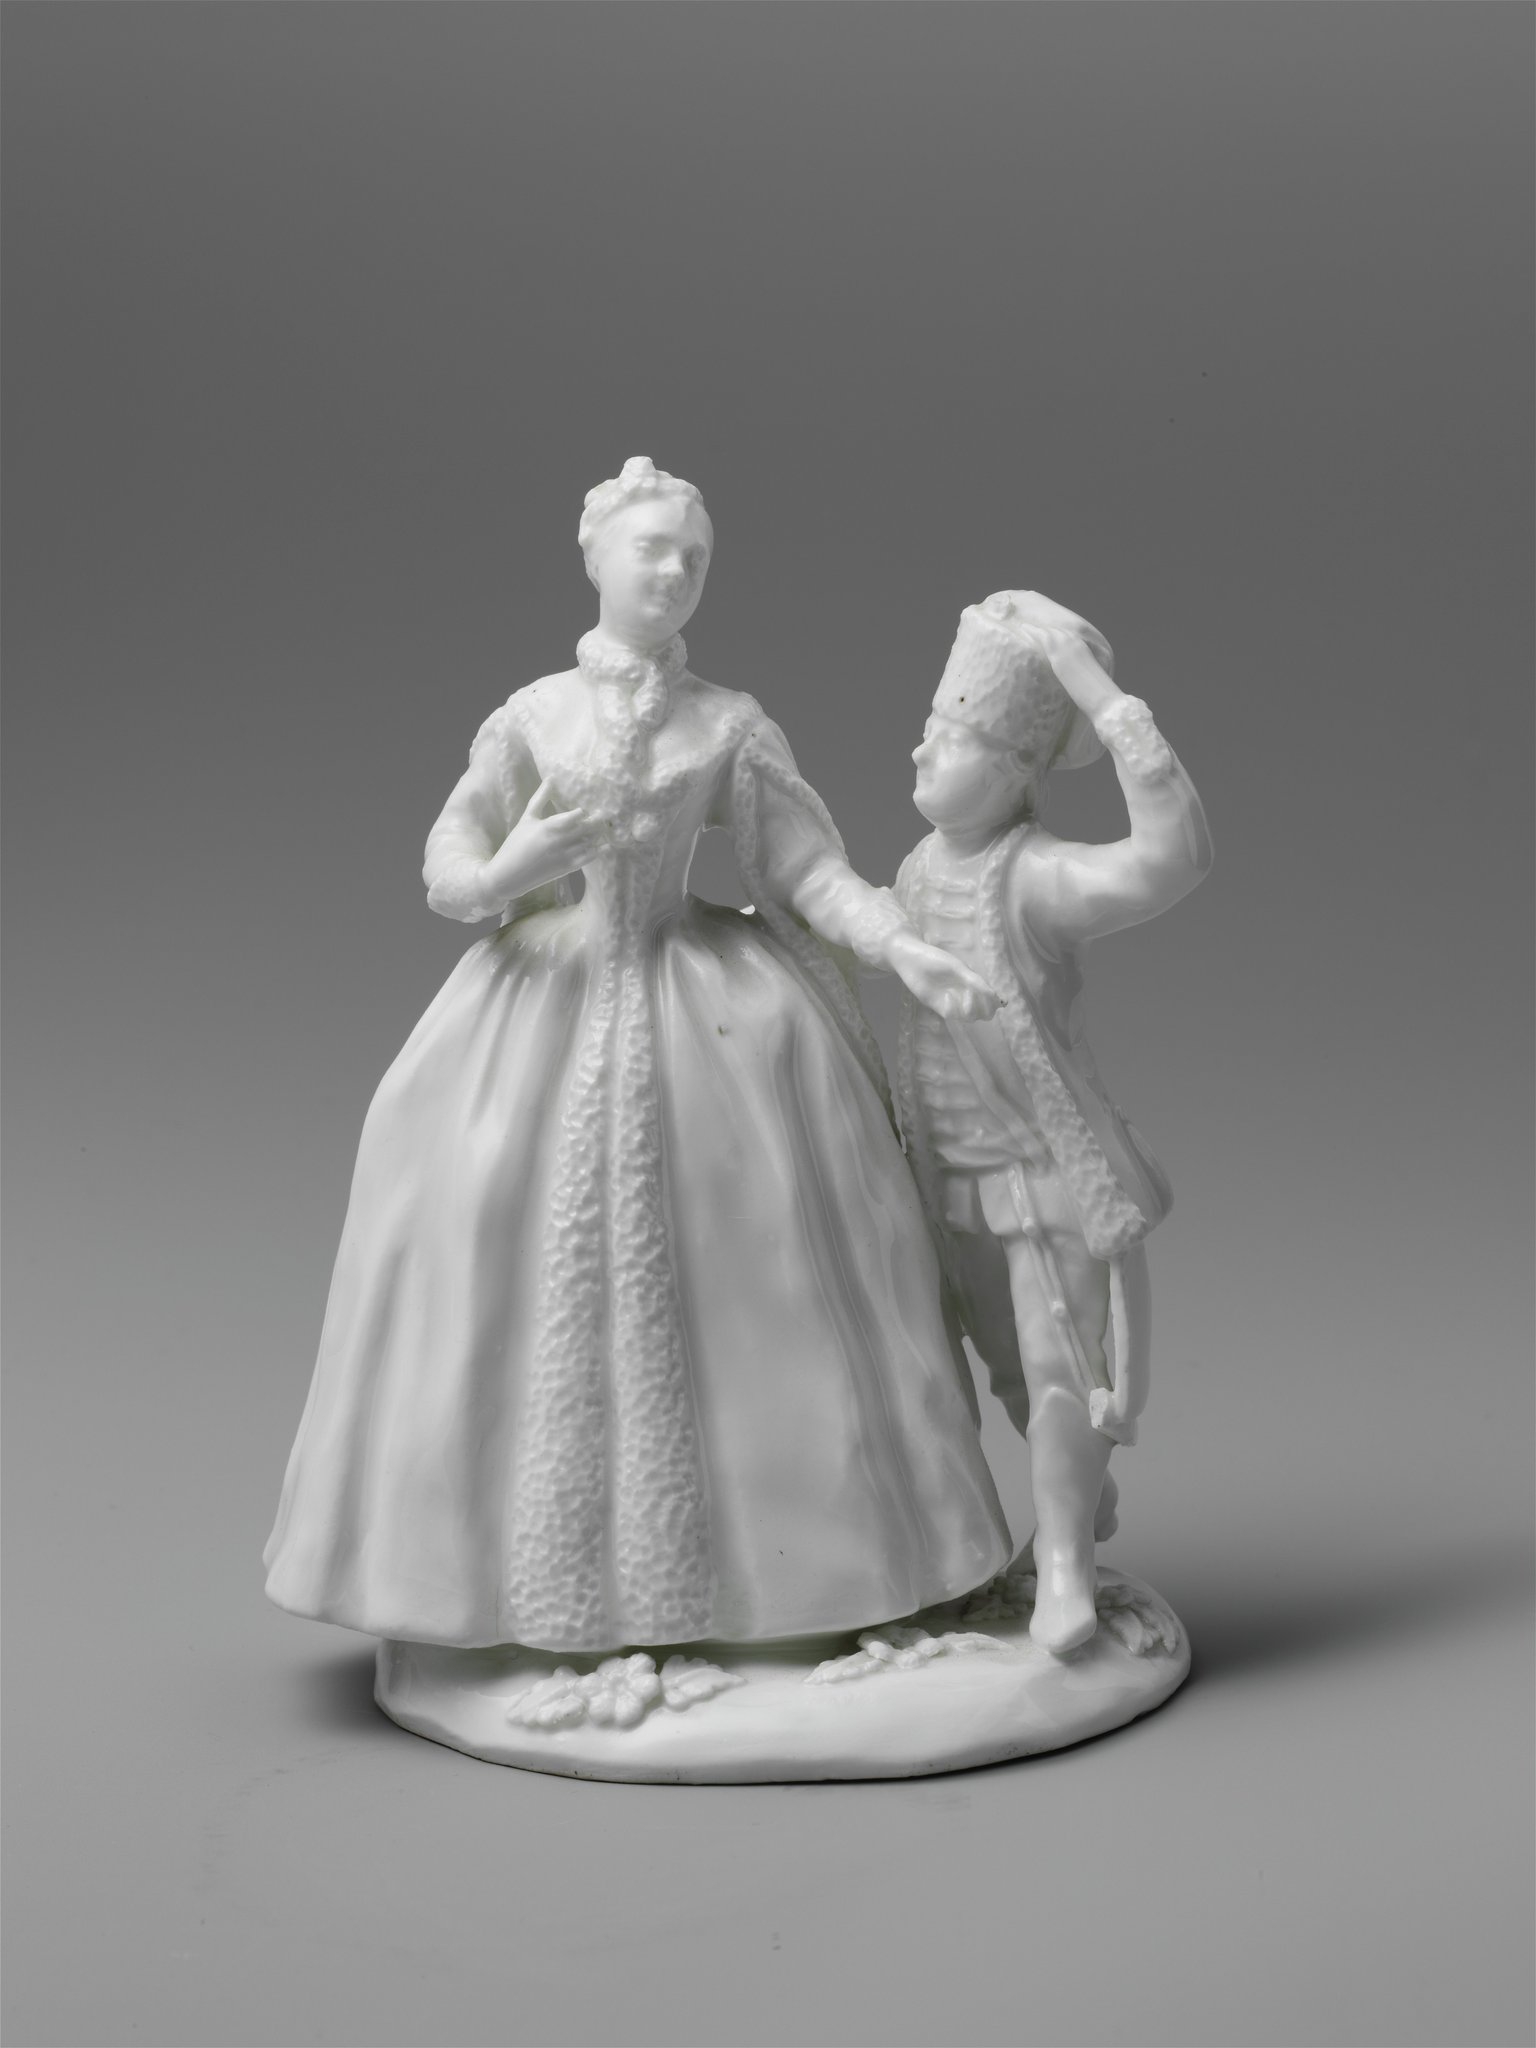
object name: group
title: Woman and Hussar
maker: imperial porcelain manufactory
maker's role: manufactory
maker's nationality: austrian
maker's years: 1744-1864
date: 1755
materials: hard paste porcelain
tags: soldiers,women